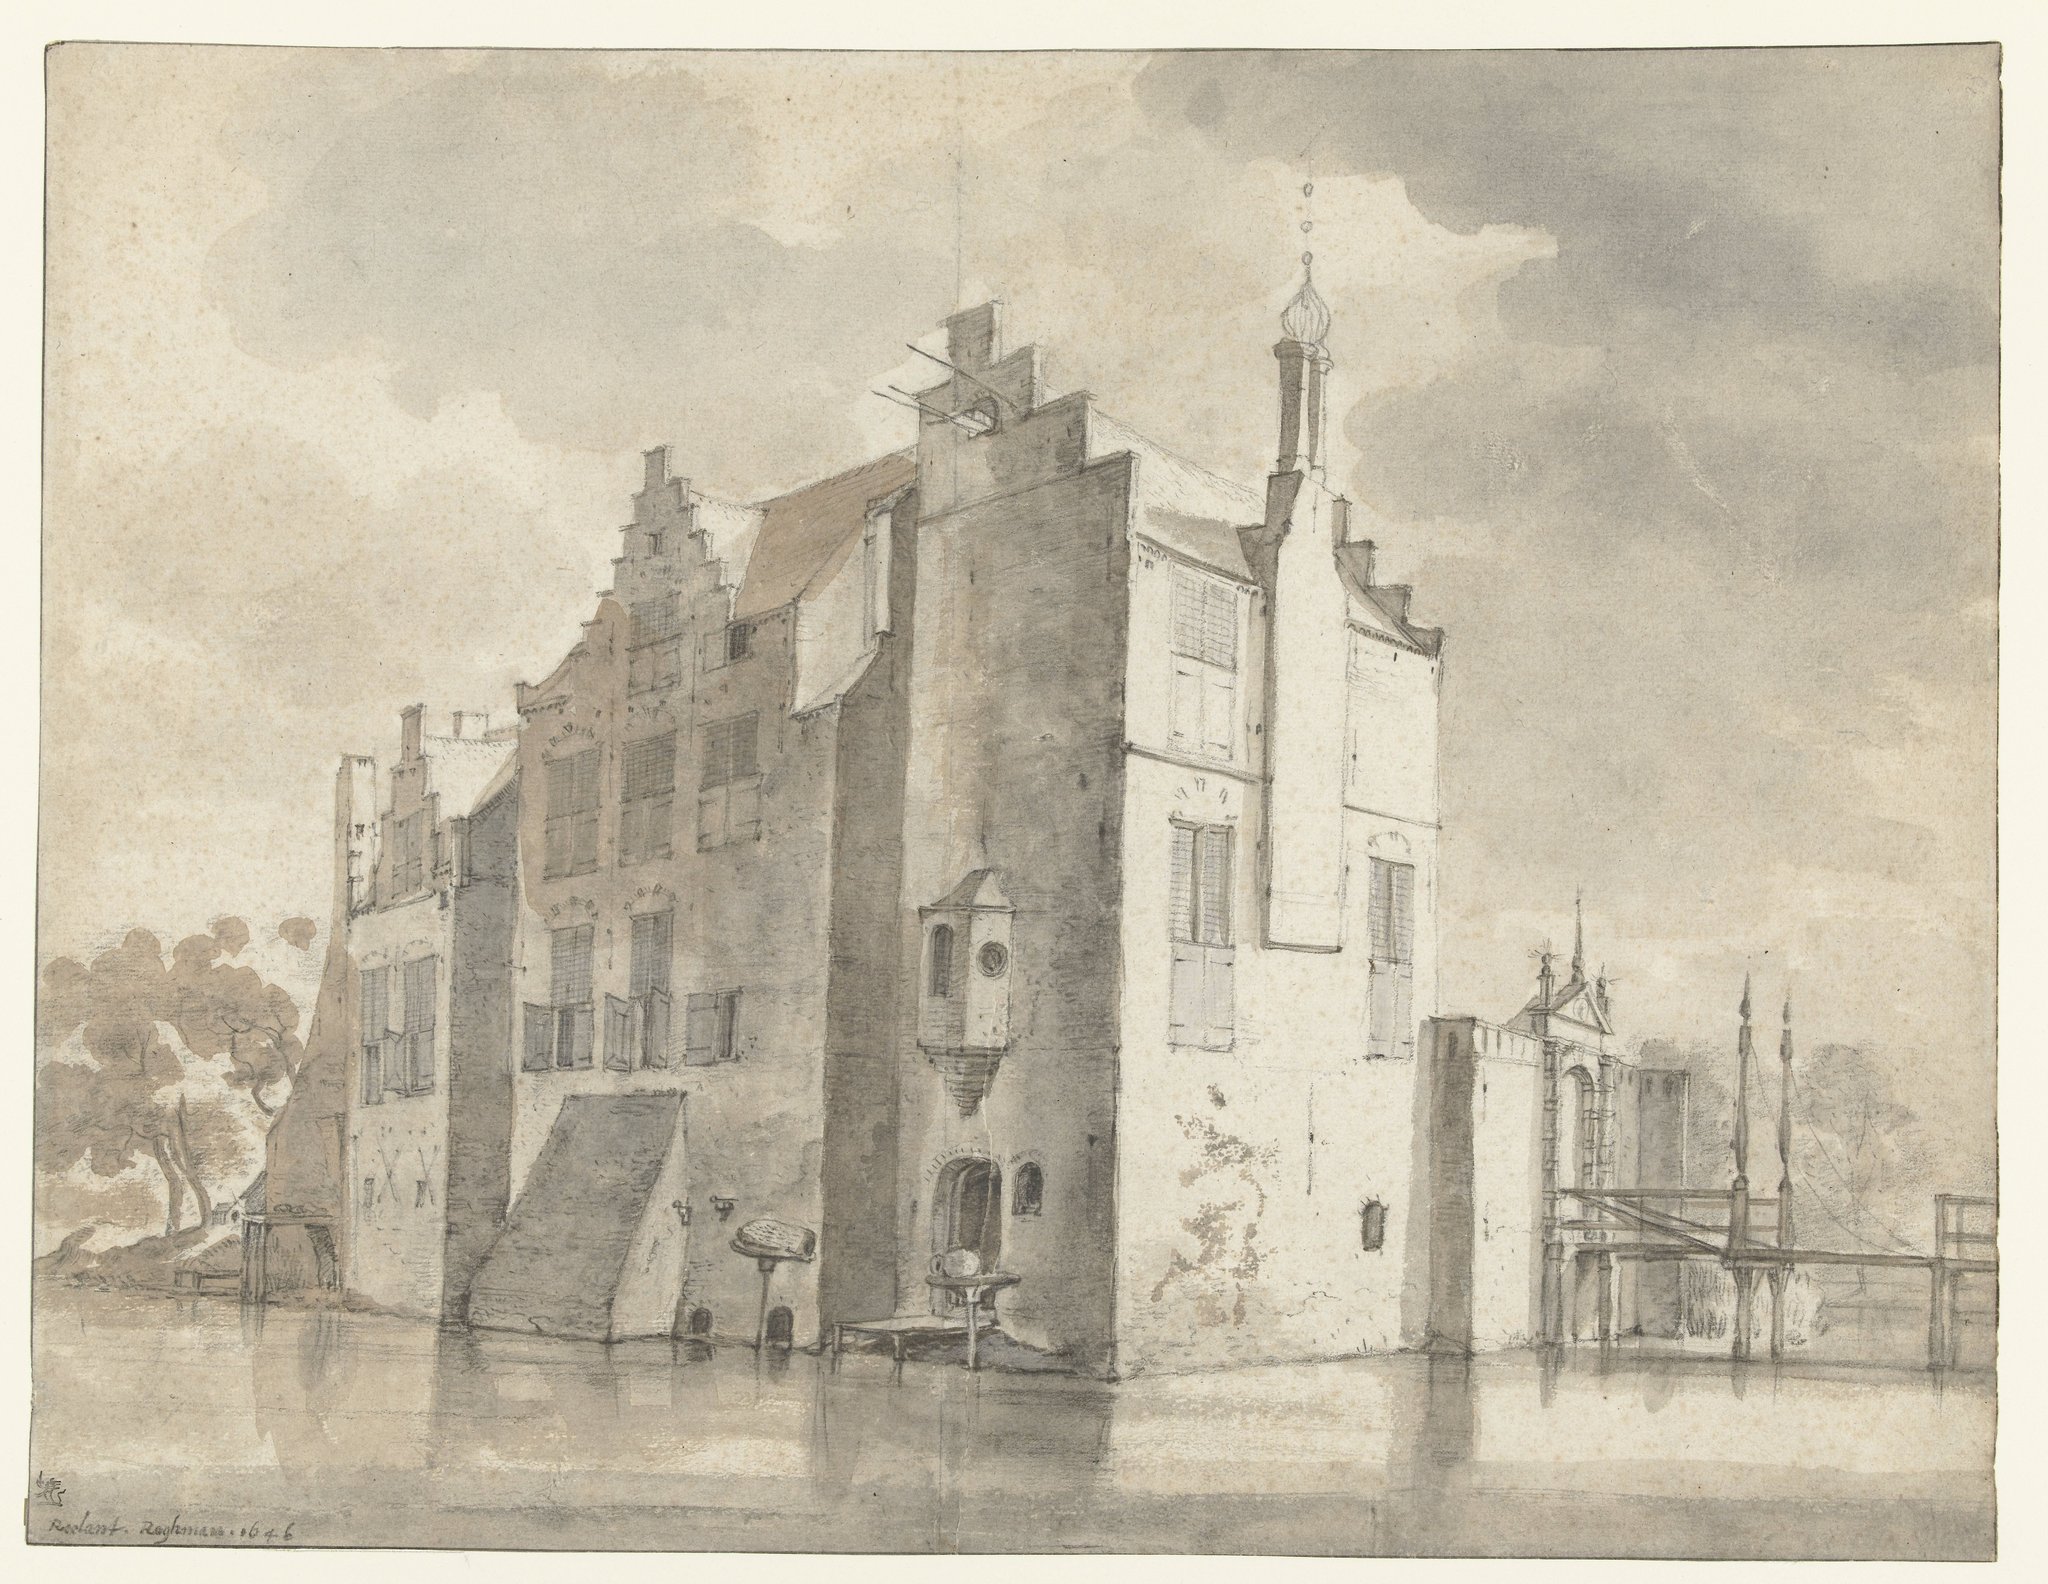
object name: drawing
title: View of Kasteel Santhorst, Seen from the North-west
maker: roelant roghman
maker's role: draughtsman, painter, print maker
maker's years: 1627-1692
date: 1646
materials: chalk, ink, paper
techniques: brush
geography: kasteel santhorst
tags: castle